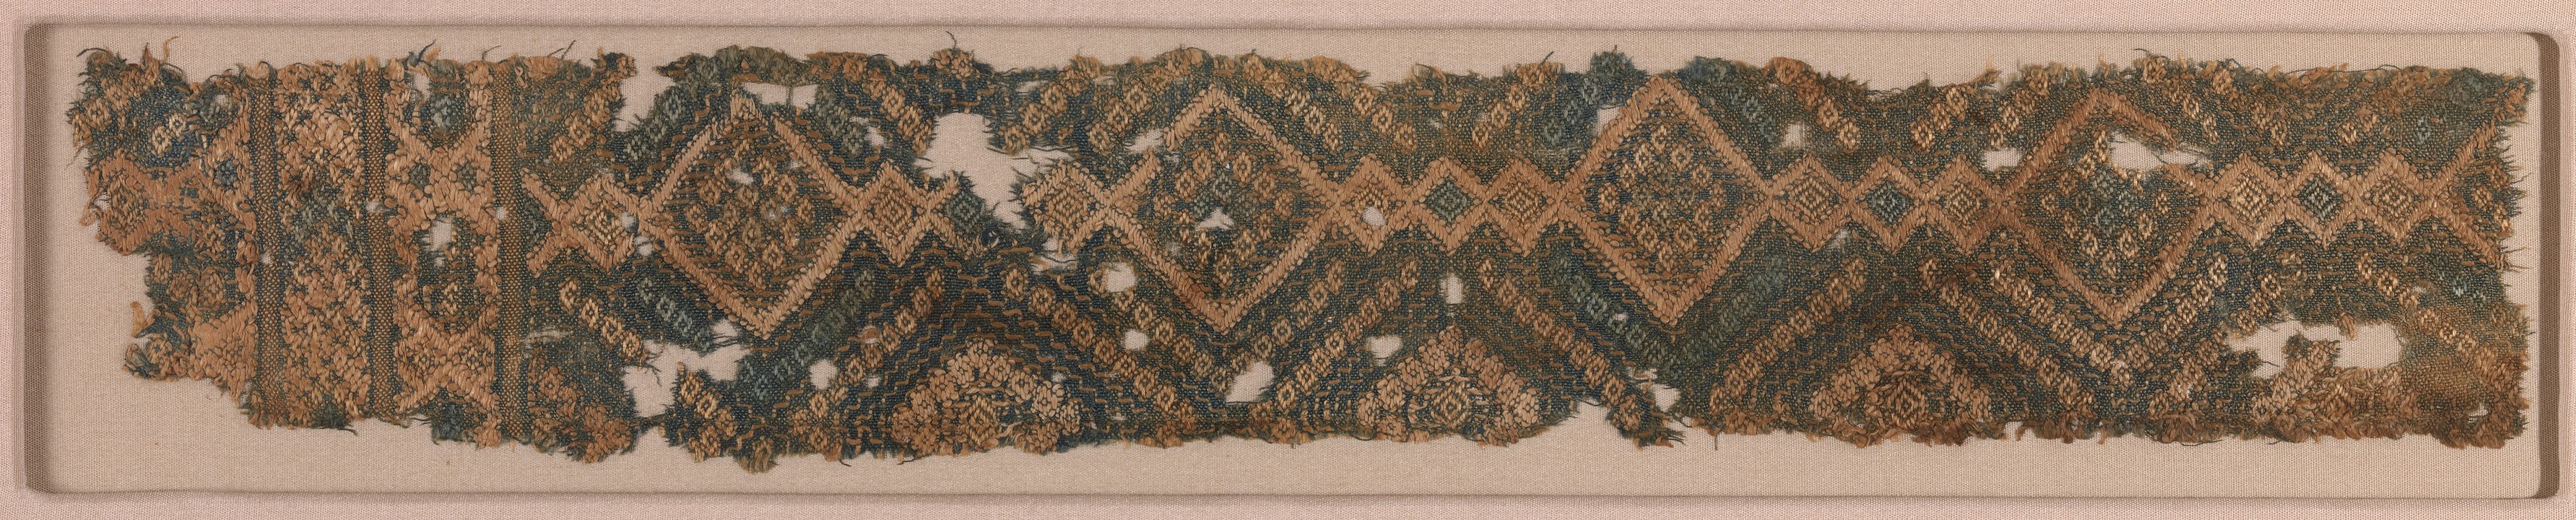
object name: textile fragment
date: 601-800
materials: linen, silk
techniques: embroidery, weave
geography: egypt